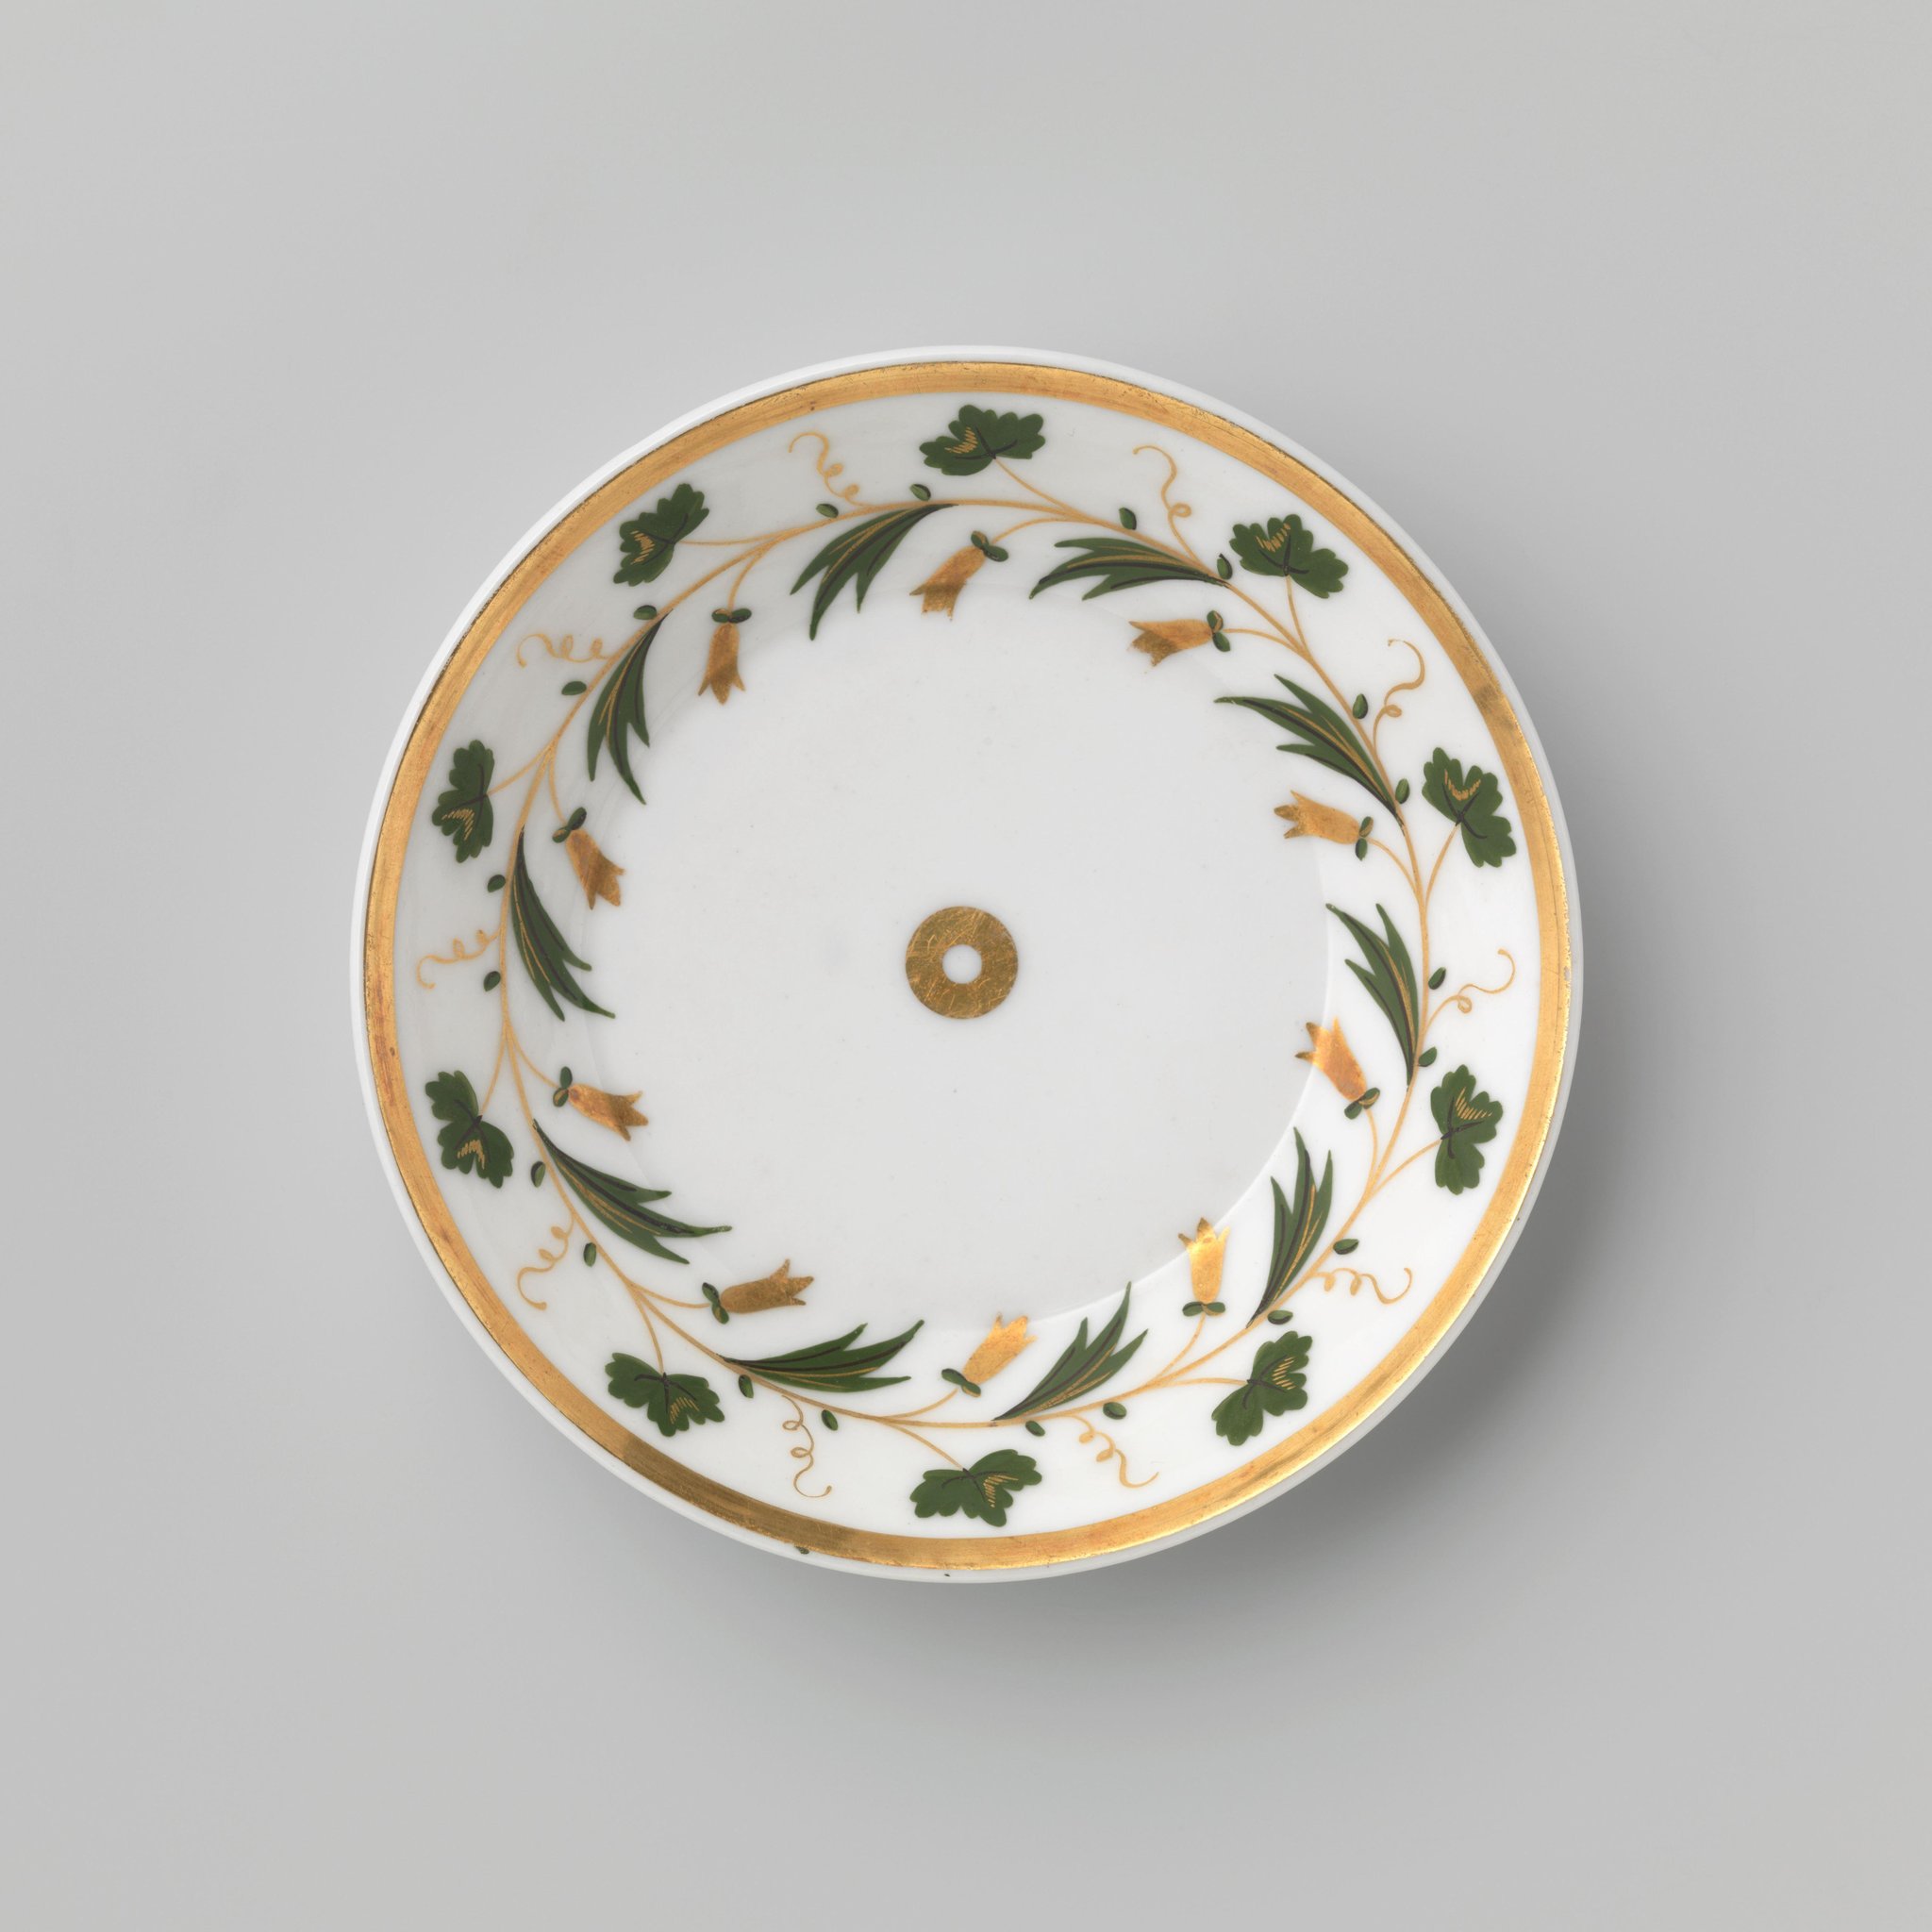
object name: platter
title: Saucer with a border of grapevines and flowers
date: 1800-1824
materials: glaze, gold, paint, porcelain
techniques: firing, forming, gilding, turning, vitrification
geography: la courtille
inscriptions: mark: ‘gekruiste pijlen’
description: Schotel van porselein met een rechte wand, beschilderd op het glazuur in groen, zwart en goud. In het centrum een gouden cirkel. Op de wand een band met aan de ene zijde wijnranken en aan de andere zijde bloemen en bladeren. Gouden rand. Gemerkt op de onderzijde met de gekruiste pijlen.